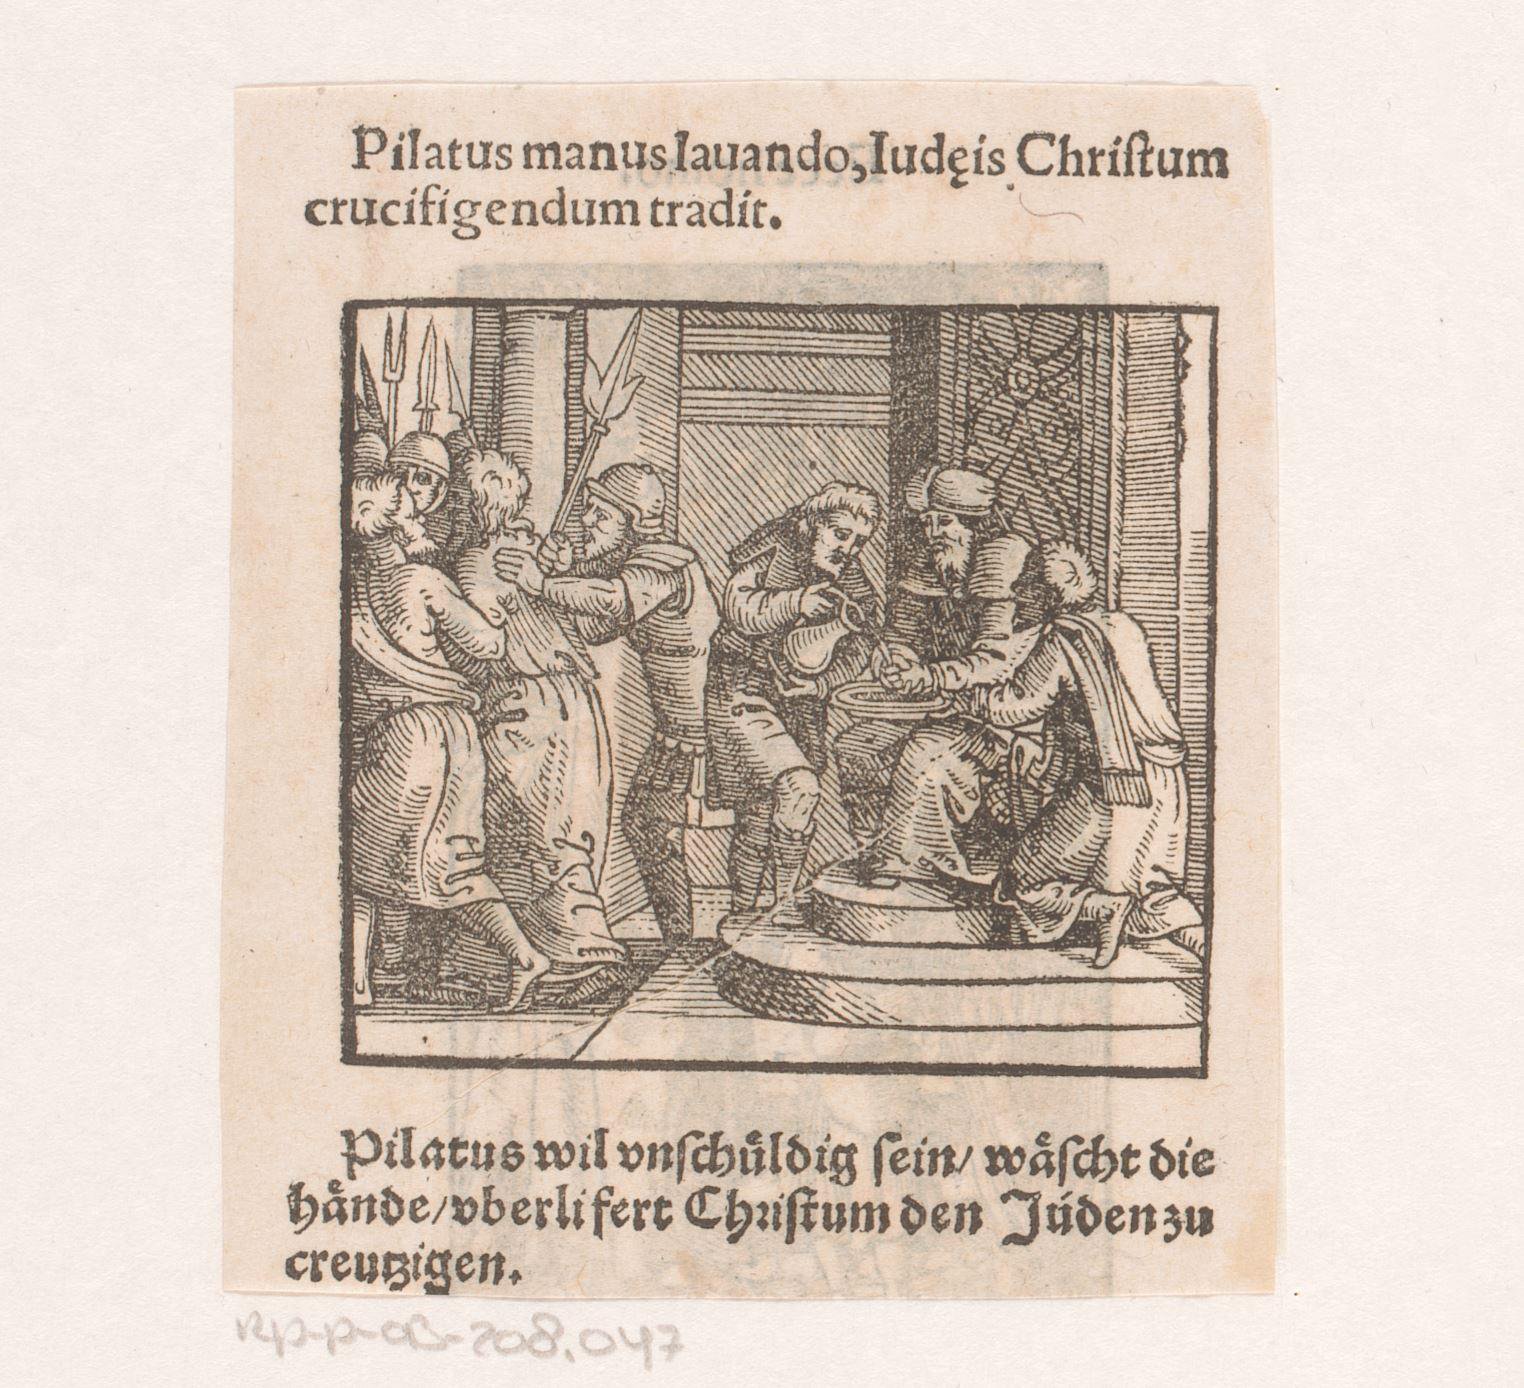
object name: book illustration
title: Pilatus wast zijn handen in onschuld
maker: Anonymous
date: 1600-1699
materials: paper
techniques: letterpress printing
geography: netherlands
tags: pilate washing his hands (in innocence)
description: Christus wordt ter dood veroordeeld en afgevoerd door soldaten. Pilatus zit op zijn troon en wast zijn handen in een schotel die bedienden voor hem volschenken met water.